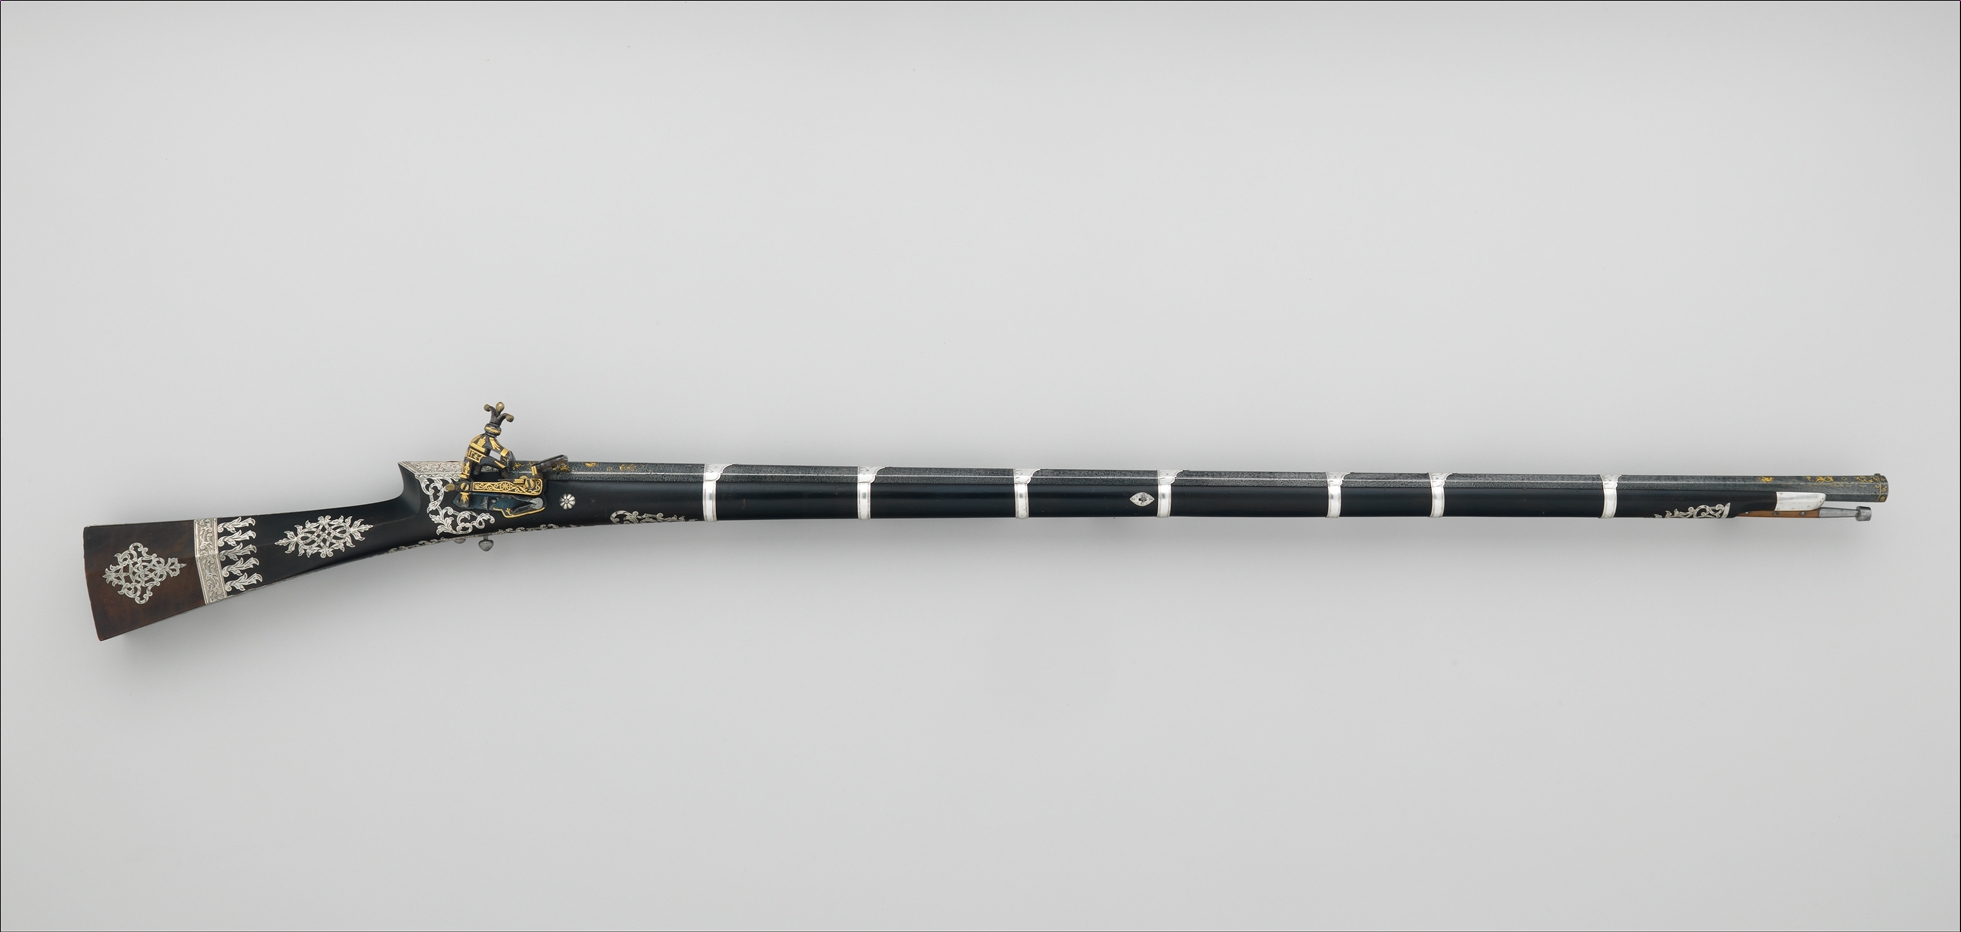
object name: miquelet rifle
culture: barrel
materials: copper alloy, gold, silver, steel, textile, wood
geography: turkey